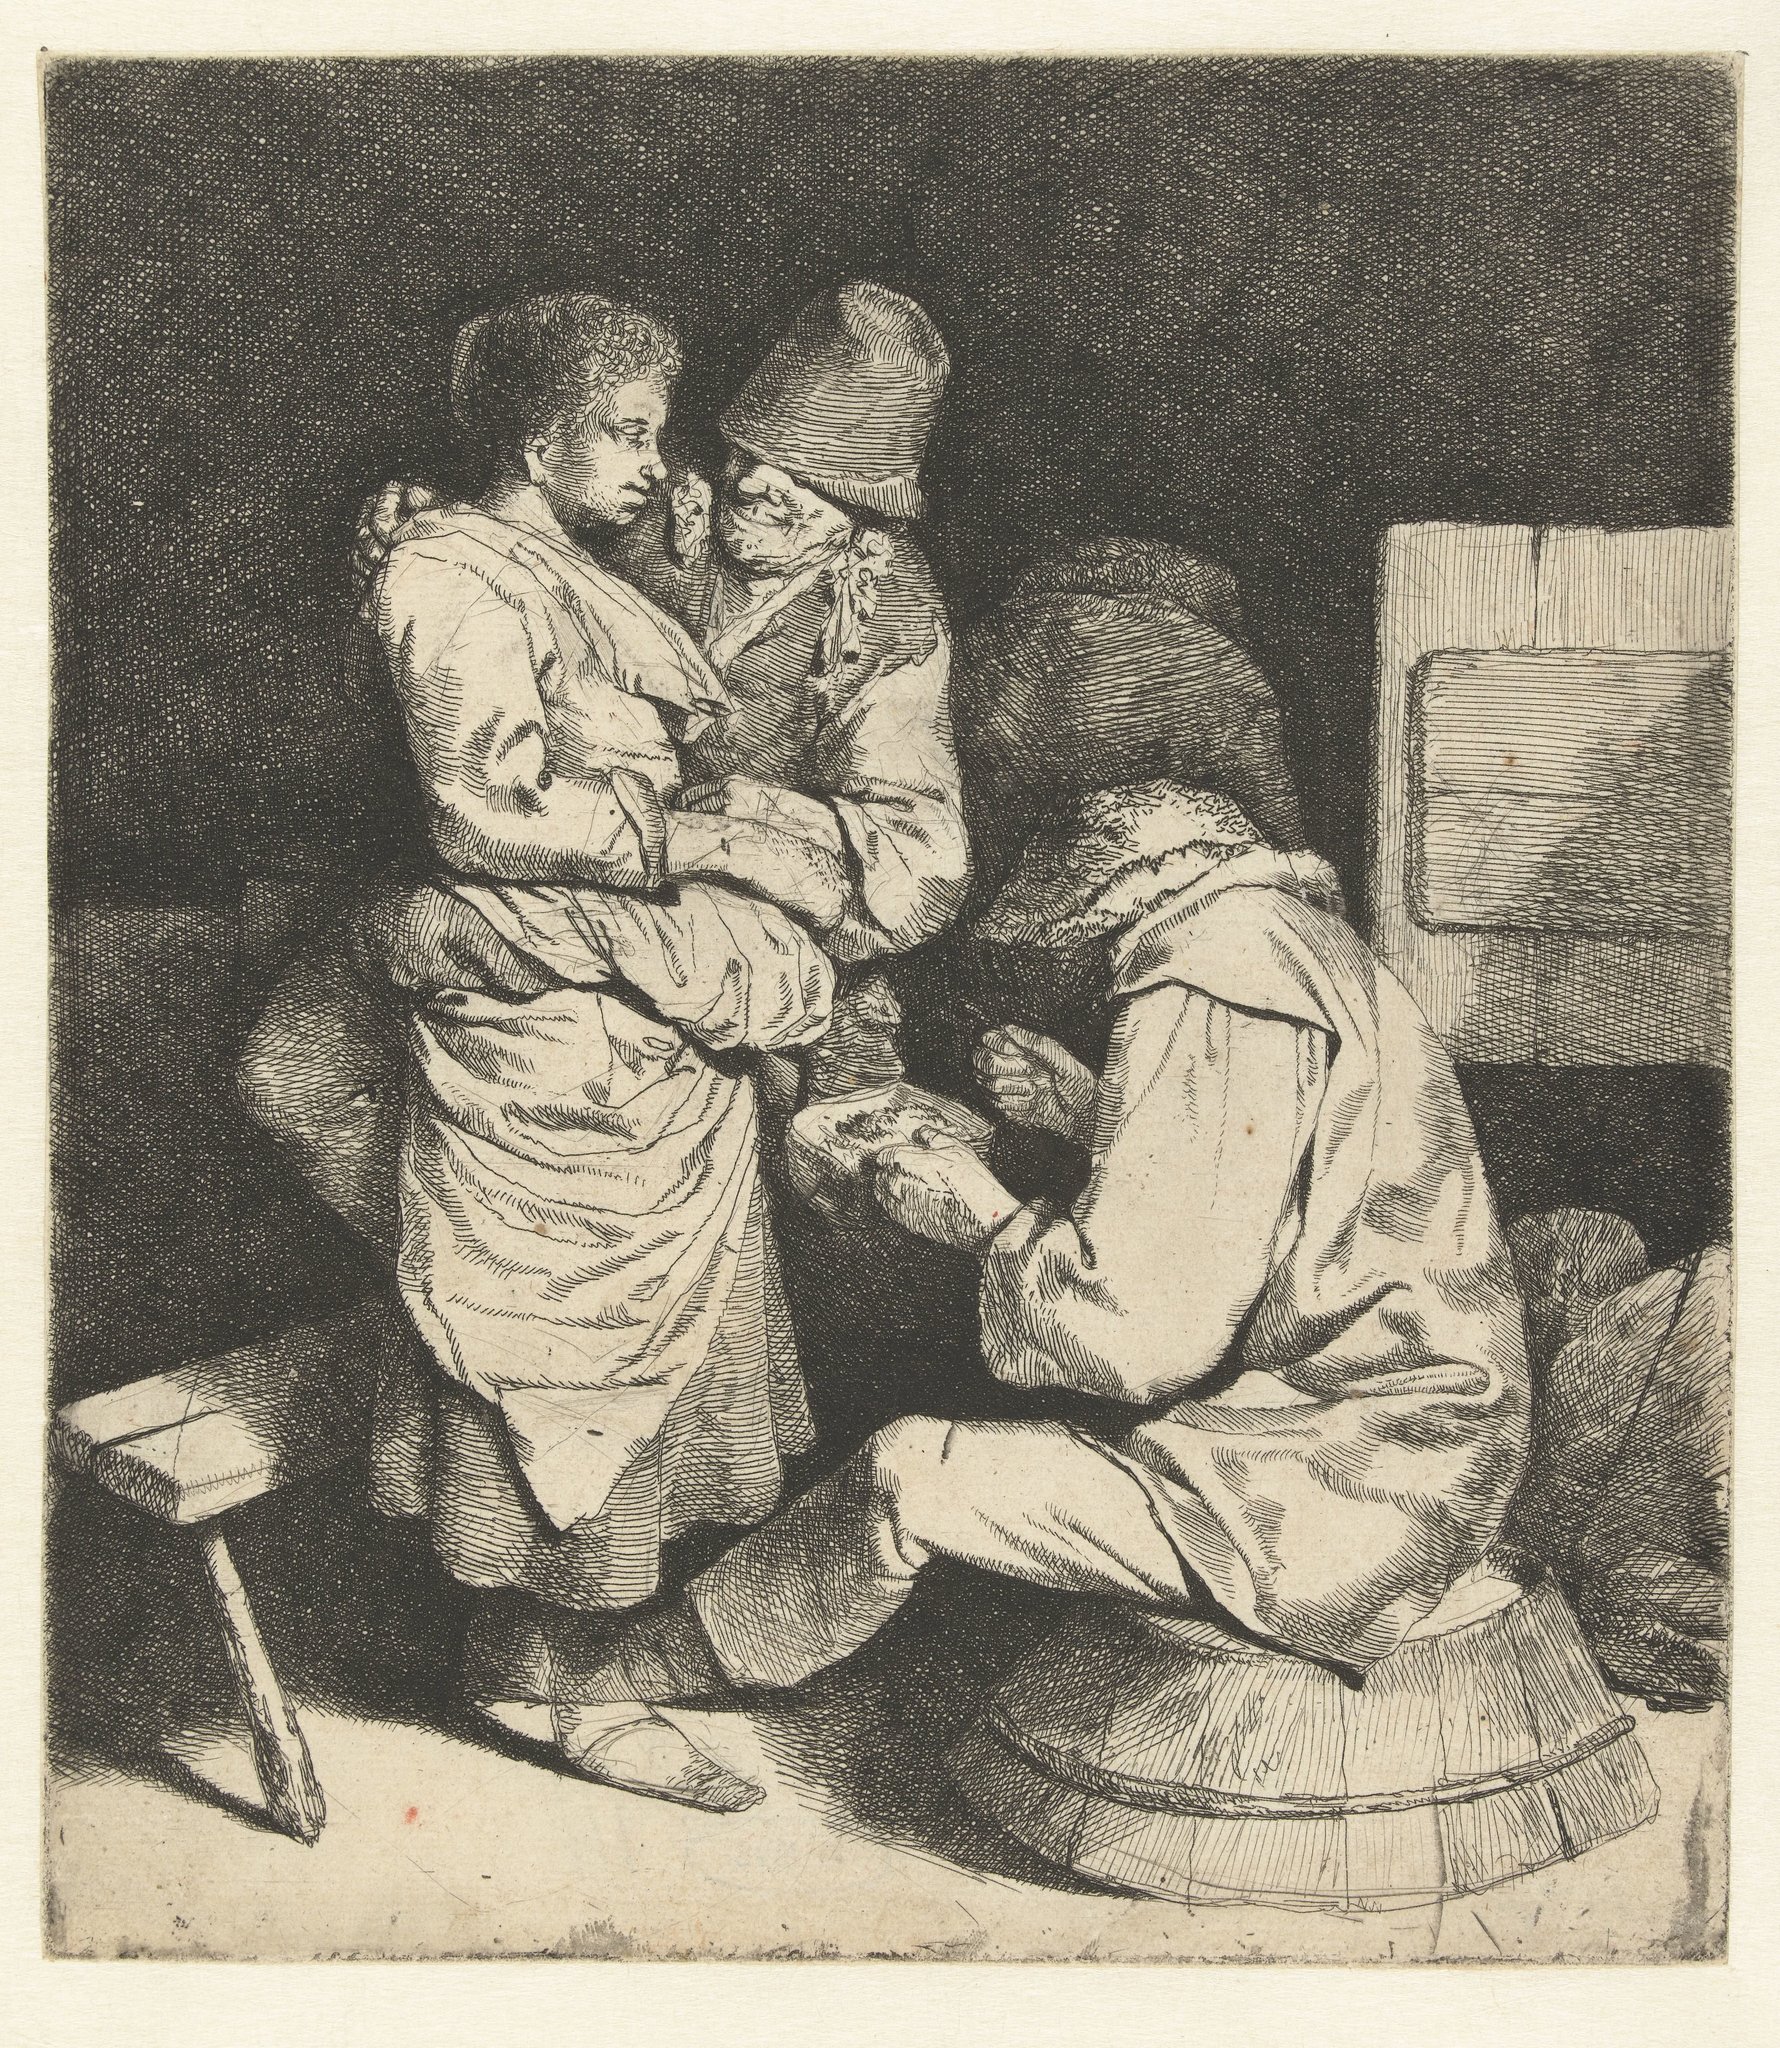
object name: print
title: De jonge waardin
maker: cornelis pietersz. bega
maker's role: draughtsman, painter, print maker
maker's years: 1631-1664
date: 1642-1664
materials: paper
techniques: etching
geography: netherlands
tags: inn, coffee-house, public house, etc.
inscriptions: collector's mark: Lugt 2228a